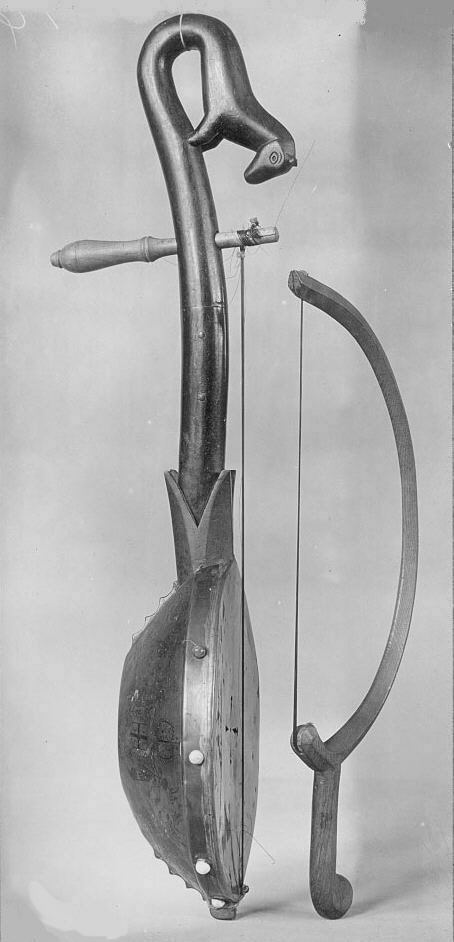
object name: gusle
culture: montenegrin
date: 1801-1900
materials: brass, wood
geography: montenegro